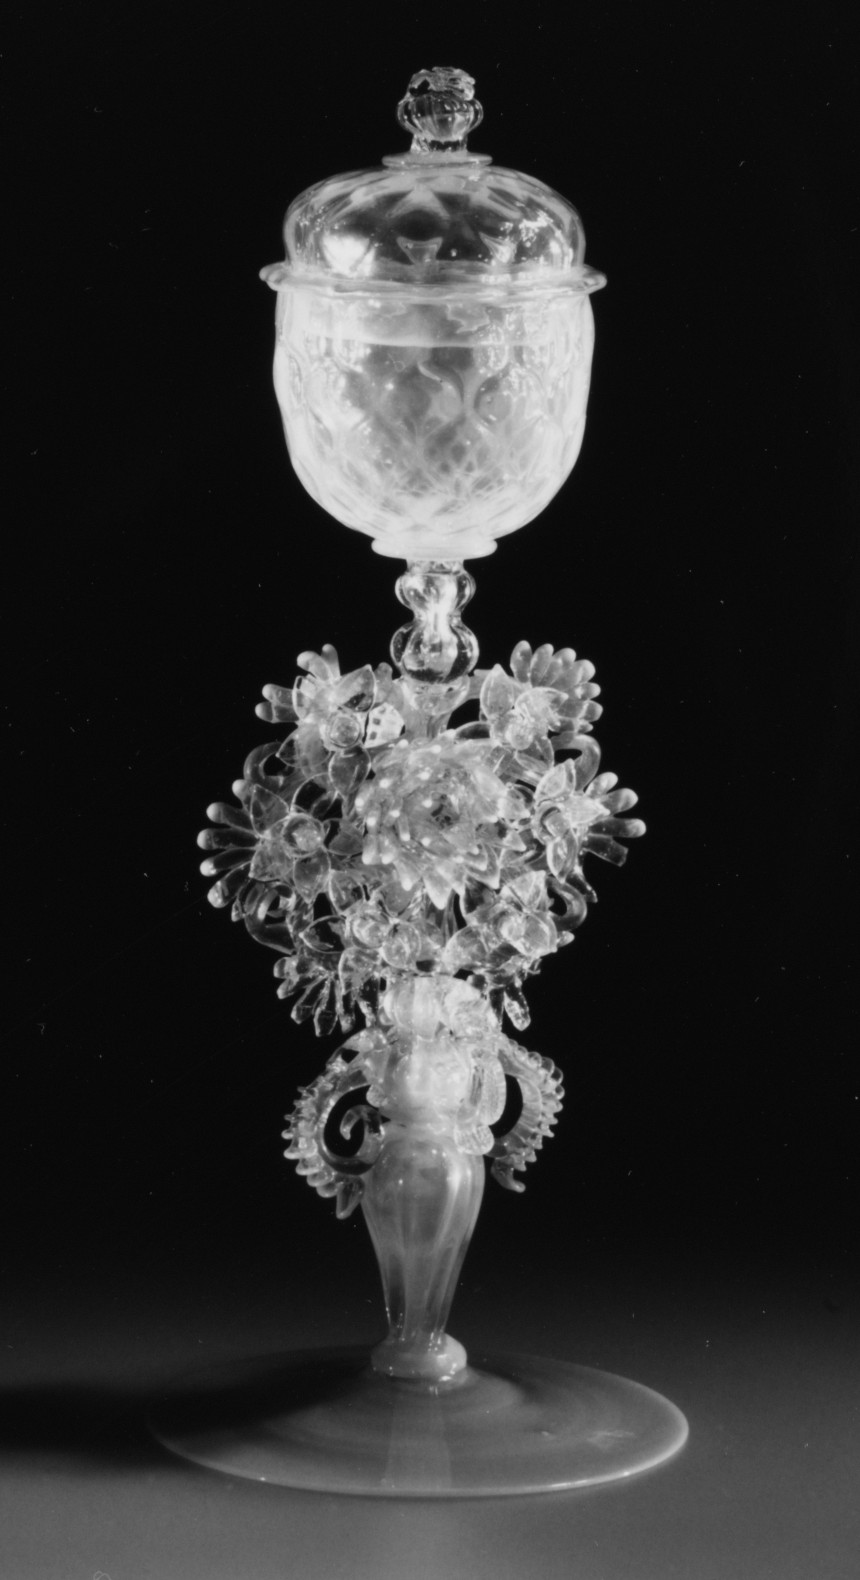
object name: goblet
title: Covered goblet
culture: italian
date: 1867-1900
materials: glass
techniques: glassblowing, molding